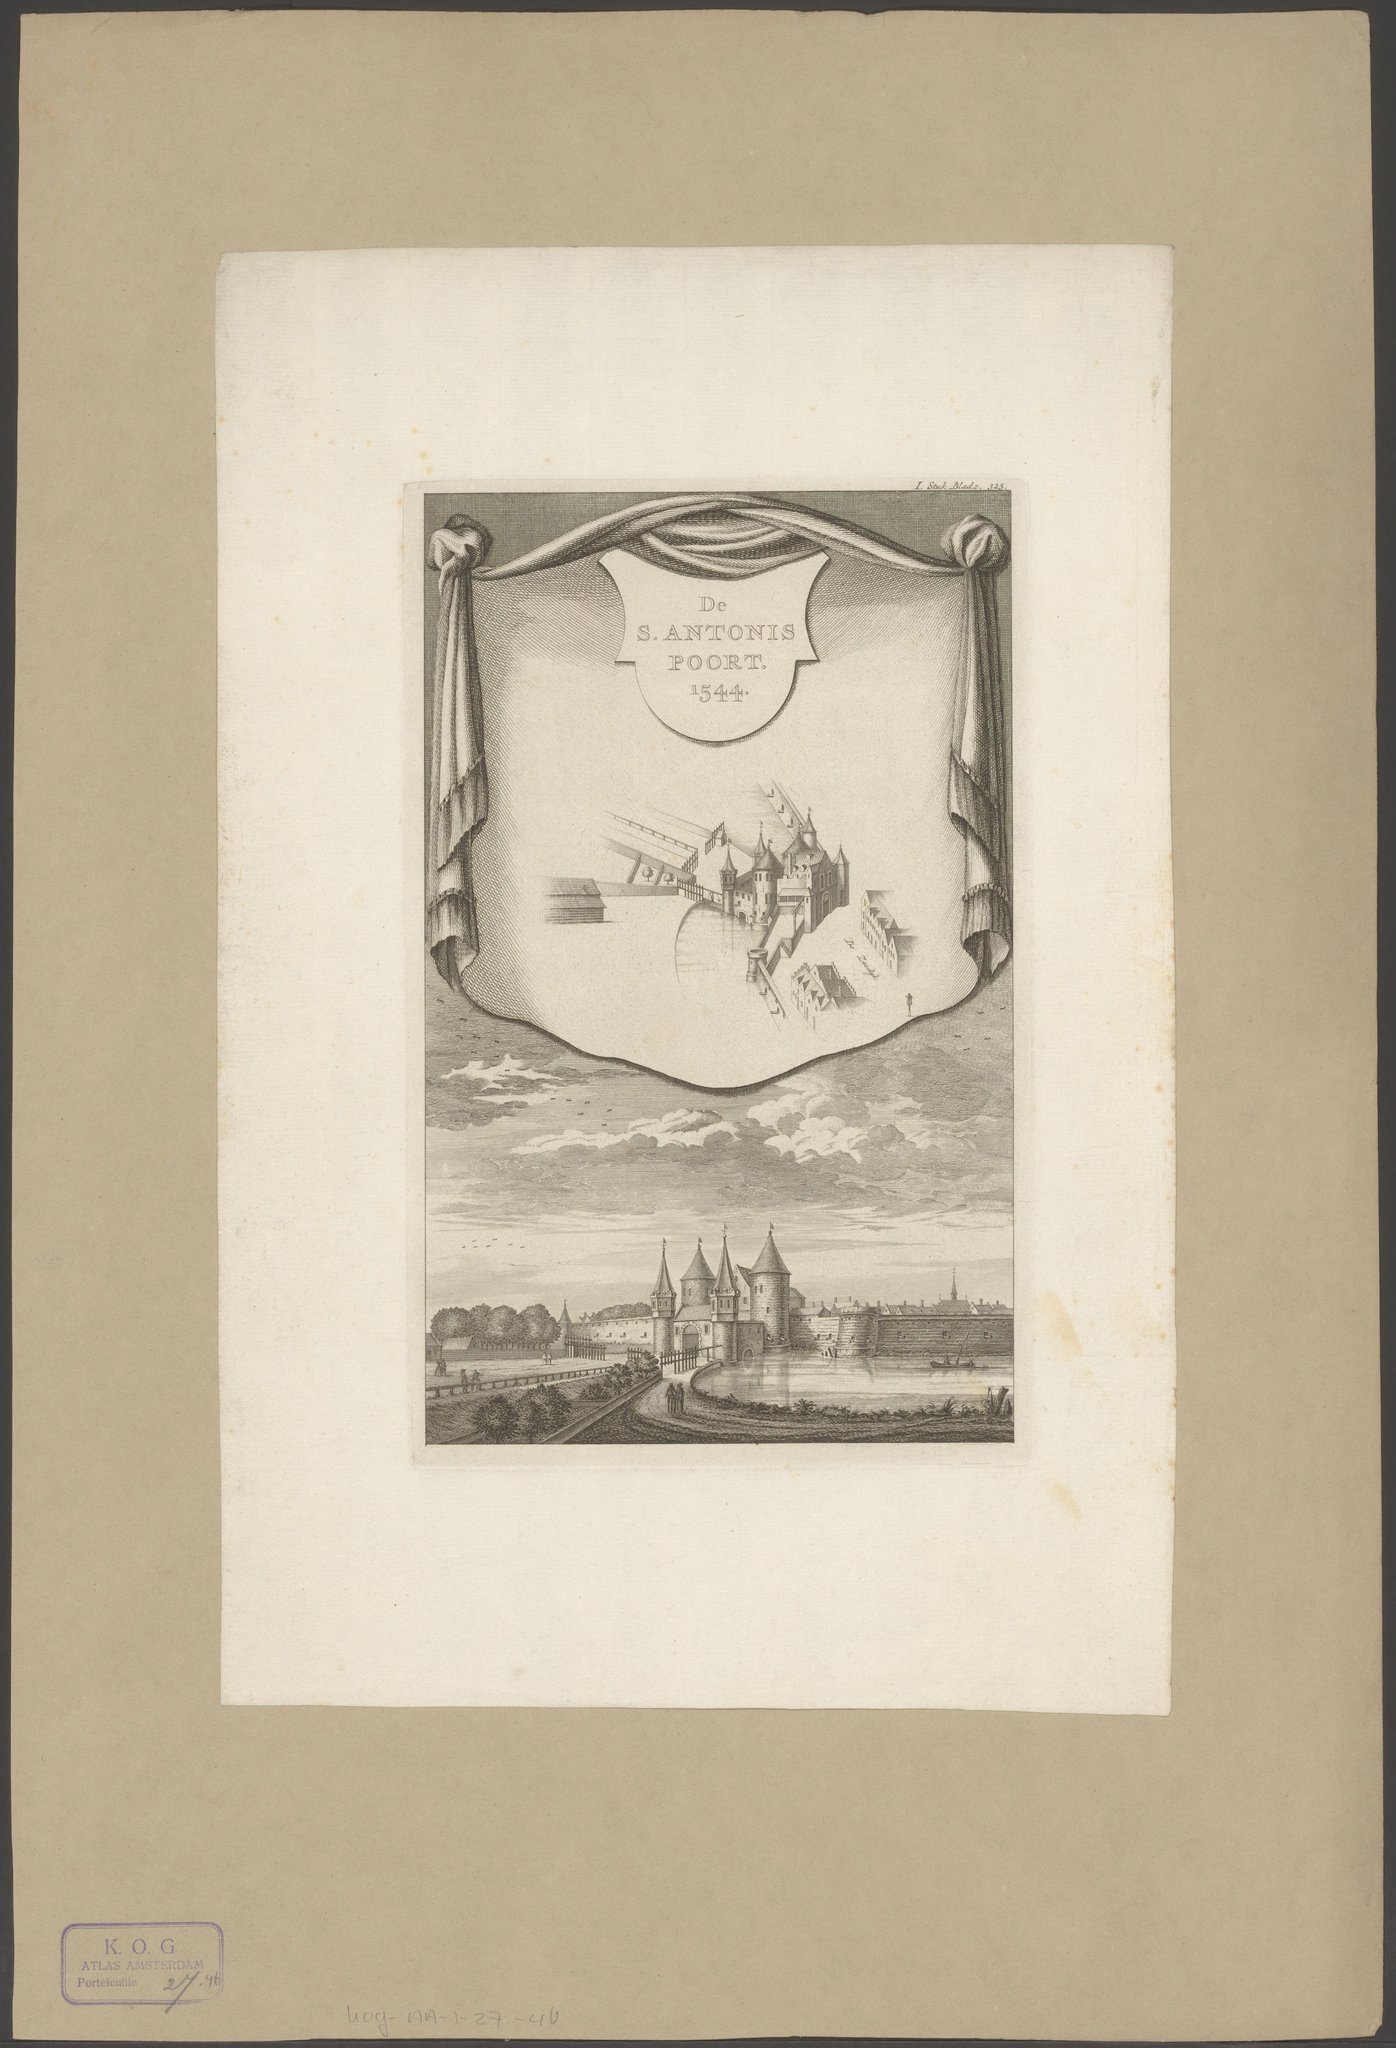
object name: print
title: Gezicht op de Eerste Sint-Antoniespoort te Amsterdam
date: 1760-1782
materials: paper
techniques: engraving, etching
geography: amsterdam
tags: bridge in city across river, canal, etc., city-gate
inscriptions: collector's mark: Lugt 1641b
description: Prent uit: Wagenaar, Jan. Amsterdam, in zyne opkomst, aanwas, geschiedenissen (...). 2 dln. Amsterdam: Isaak Tirion, 1760, dl. 1, p. 325. Of uit een latere publicatie: Verzameling der fraaiste gezigten van Amsterdam. Amsterdam: Petrus Conradi, Harlingen: V. van der Plaats, 1782.